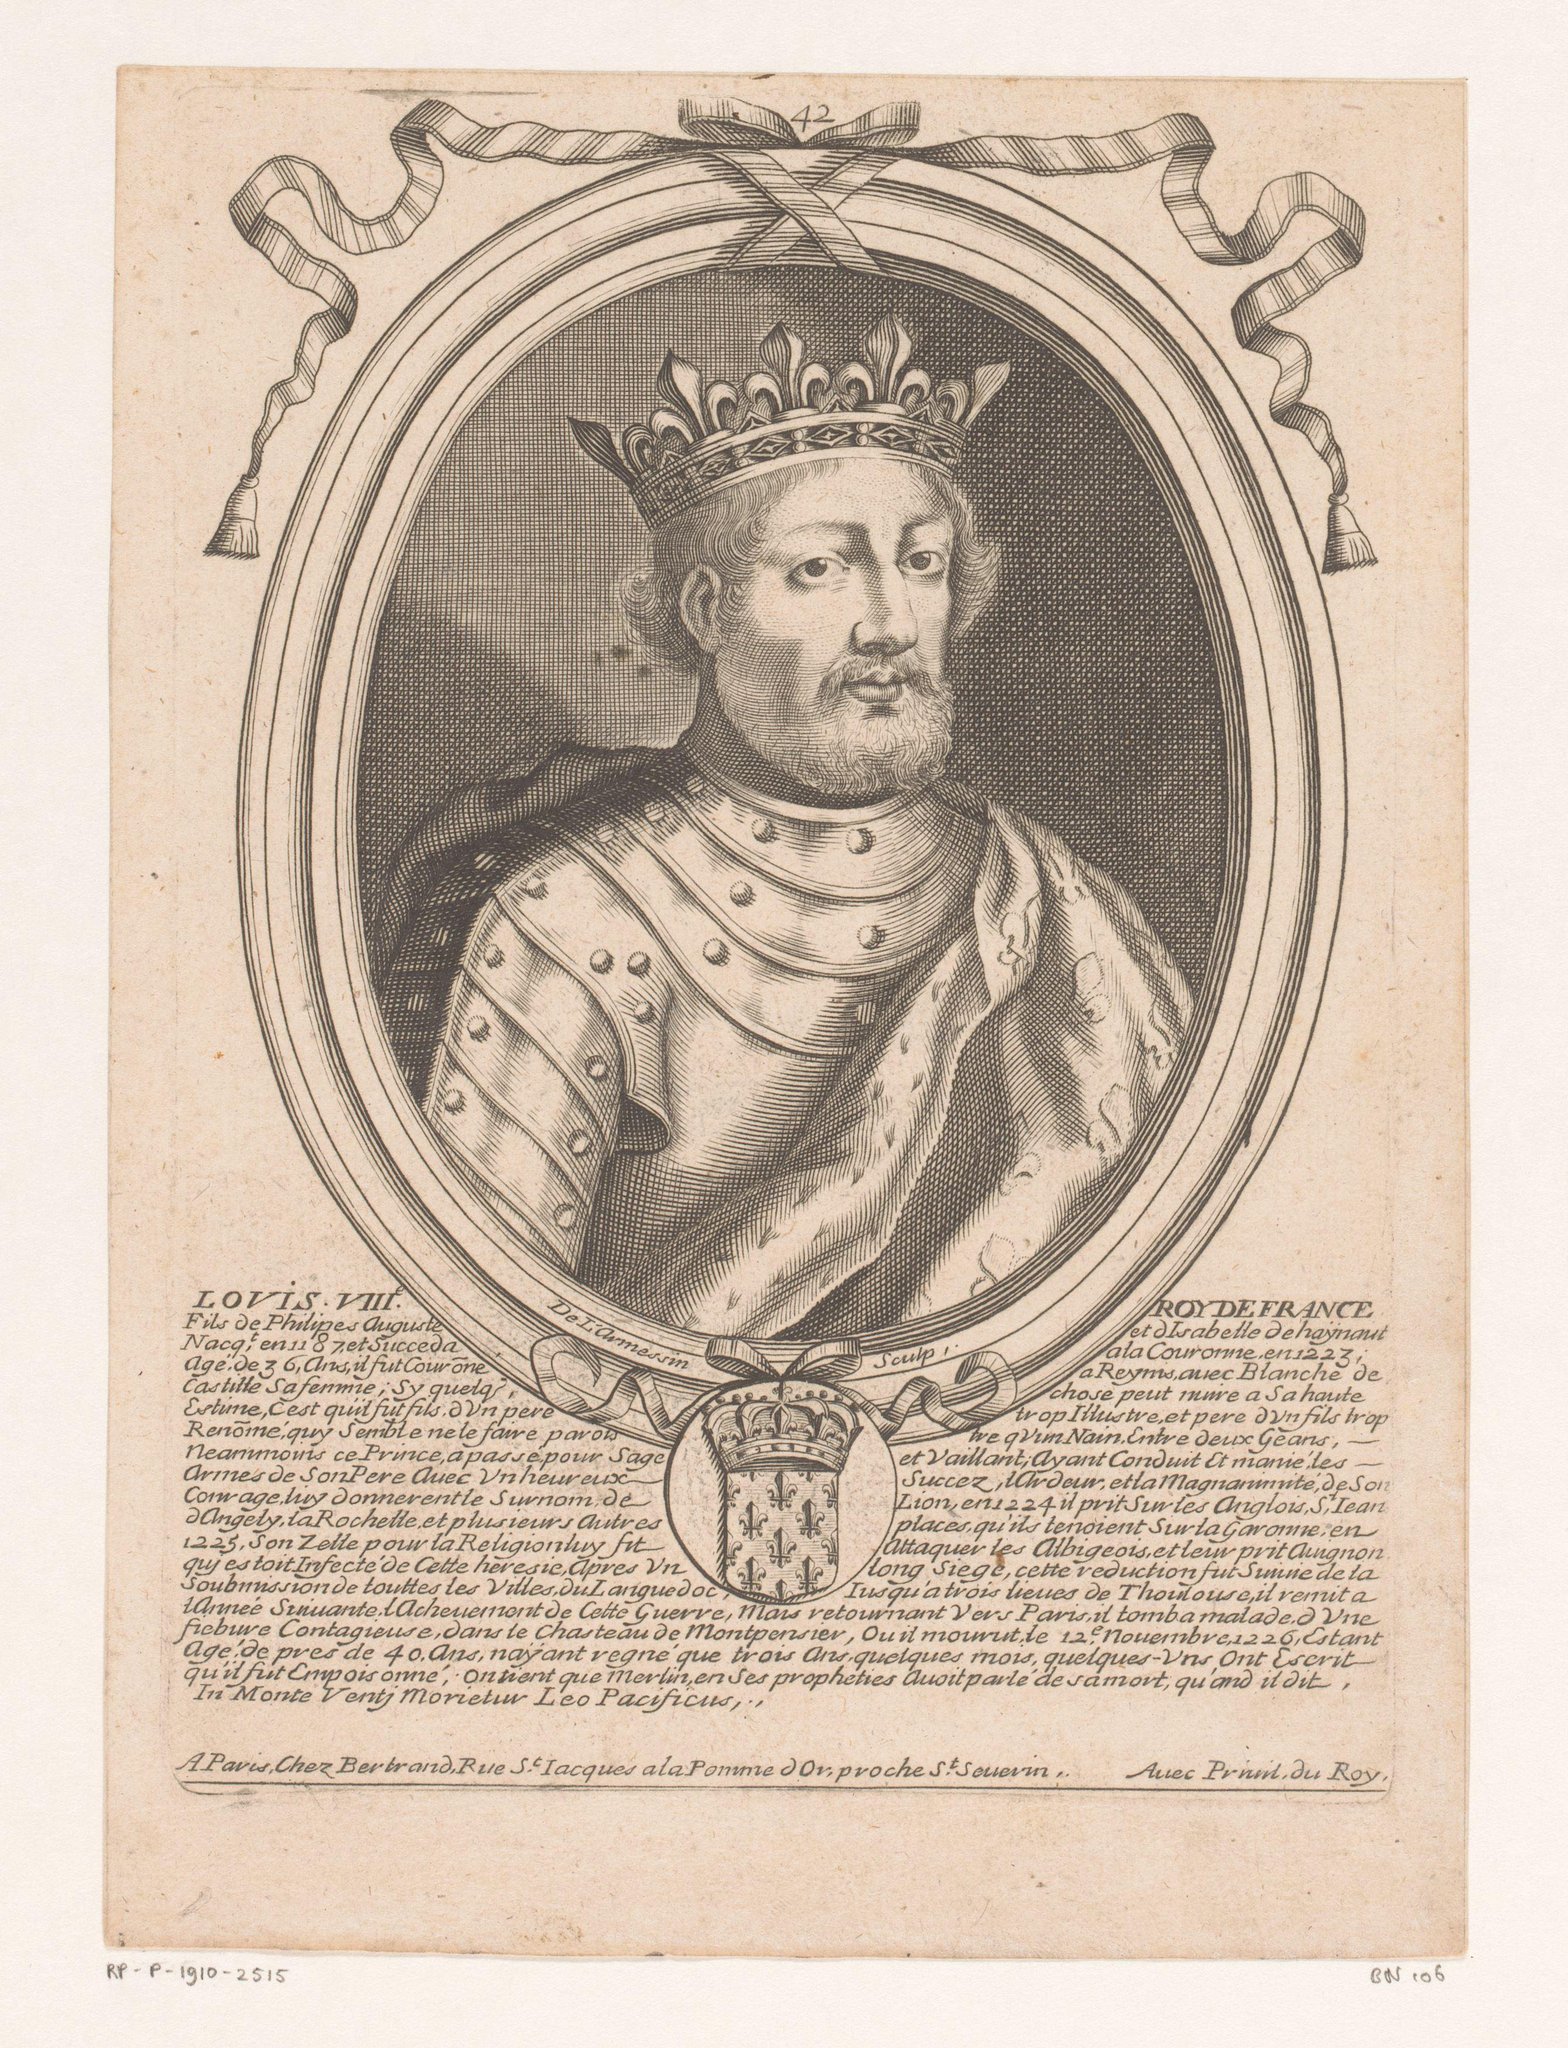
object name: print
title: Louis VIII Roy de France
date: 1642-1678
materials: paper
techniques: engraving, etching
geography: france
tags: paris, historical persons, king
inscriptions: collector's mark: Lugt 2228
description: Maakt deel uit van een grootschalige serie met portretten van prominente figuren. Binnen de serie bevindt zich een sectie getiteld 'Les Augustes Représentations De tous les Roys De France depuis Pharamond Iusqu'à Louys XIIII'. De serie werd respectievelijk uitgegeven door Pierre Bertrand, door zijn weduwe en door De Larmessin zelf.